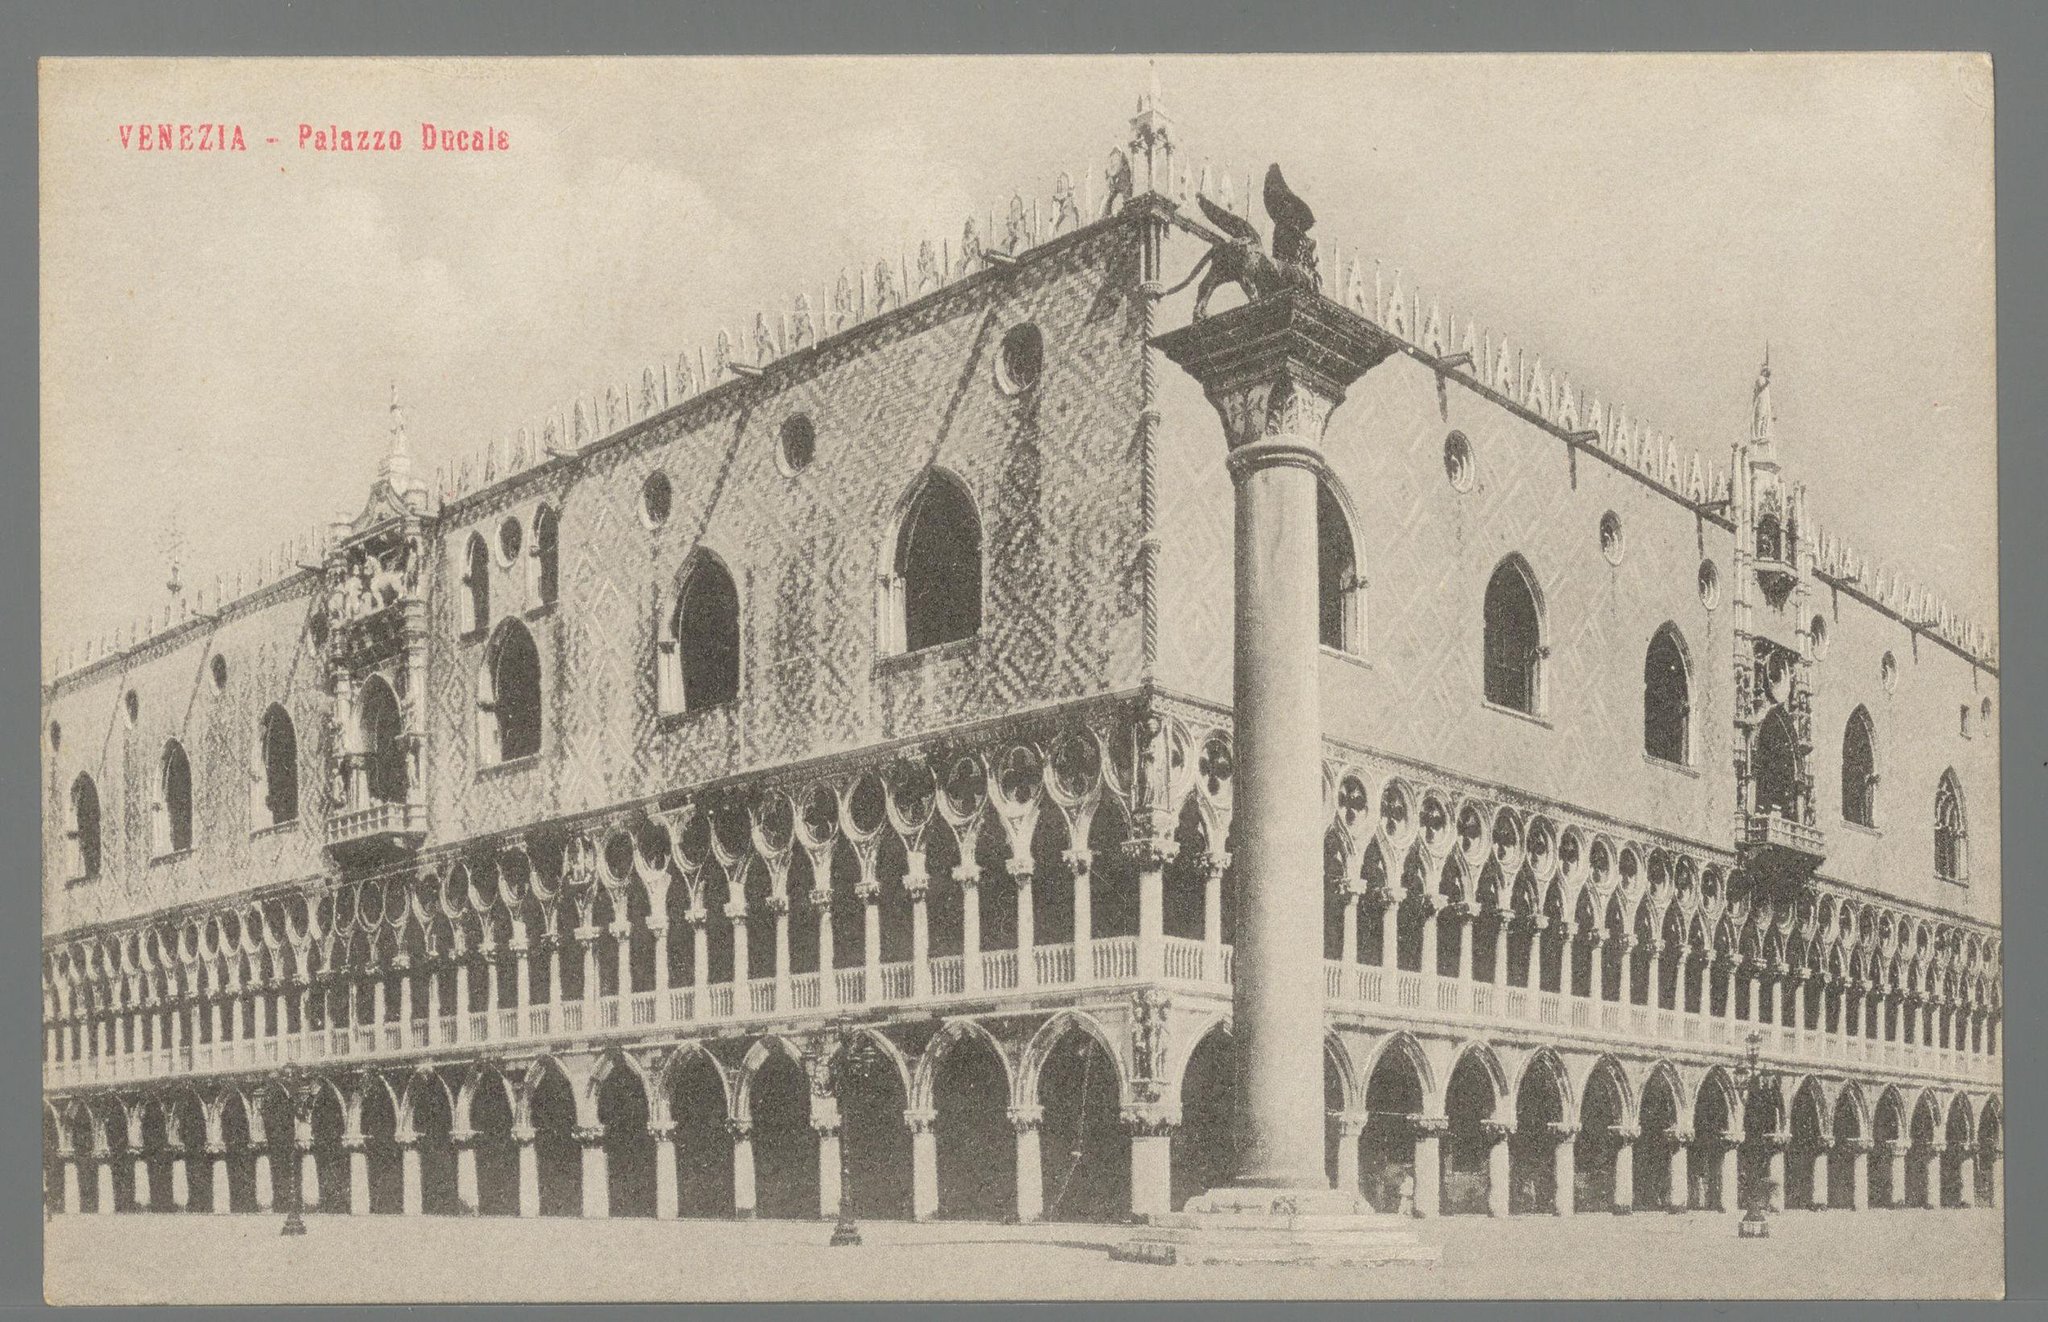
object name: ansichtkaart, prentbriefkaart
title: Venezia. Palazzo Ducale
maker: Anonymous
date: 1906-1920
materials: cardboard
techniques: photograph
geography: venice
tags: palace, monument, statue